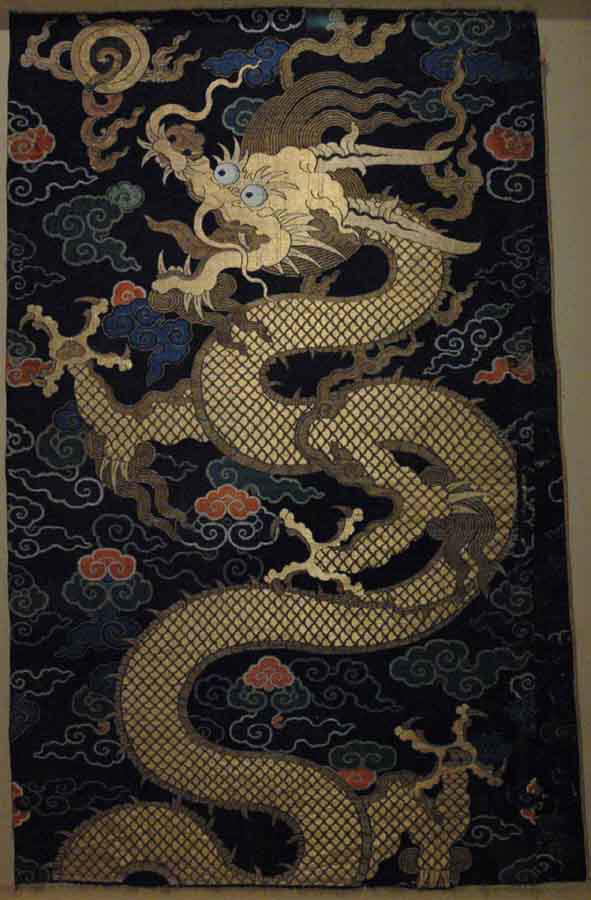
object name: panel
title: Panel with dragon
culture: chinese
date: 1601-1700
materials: metal thread, silk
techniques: brocade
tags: dragons